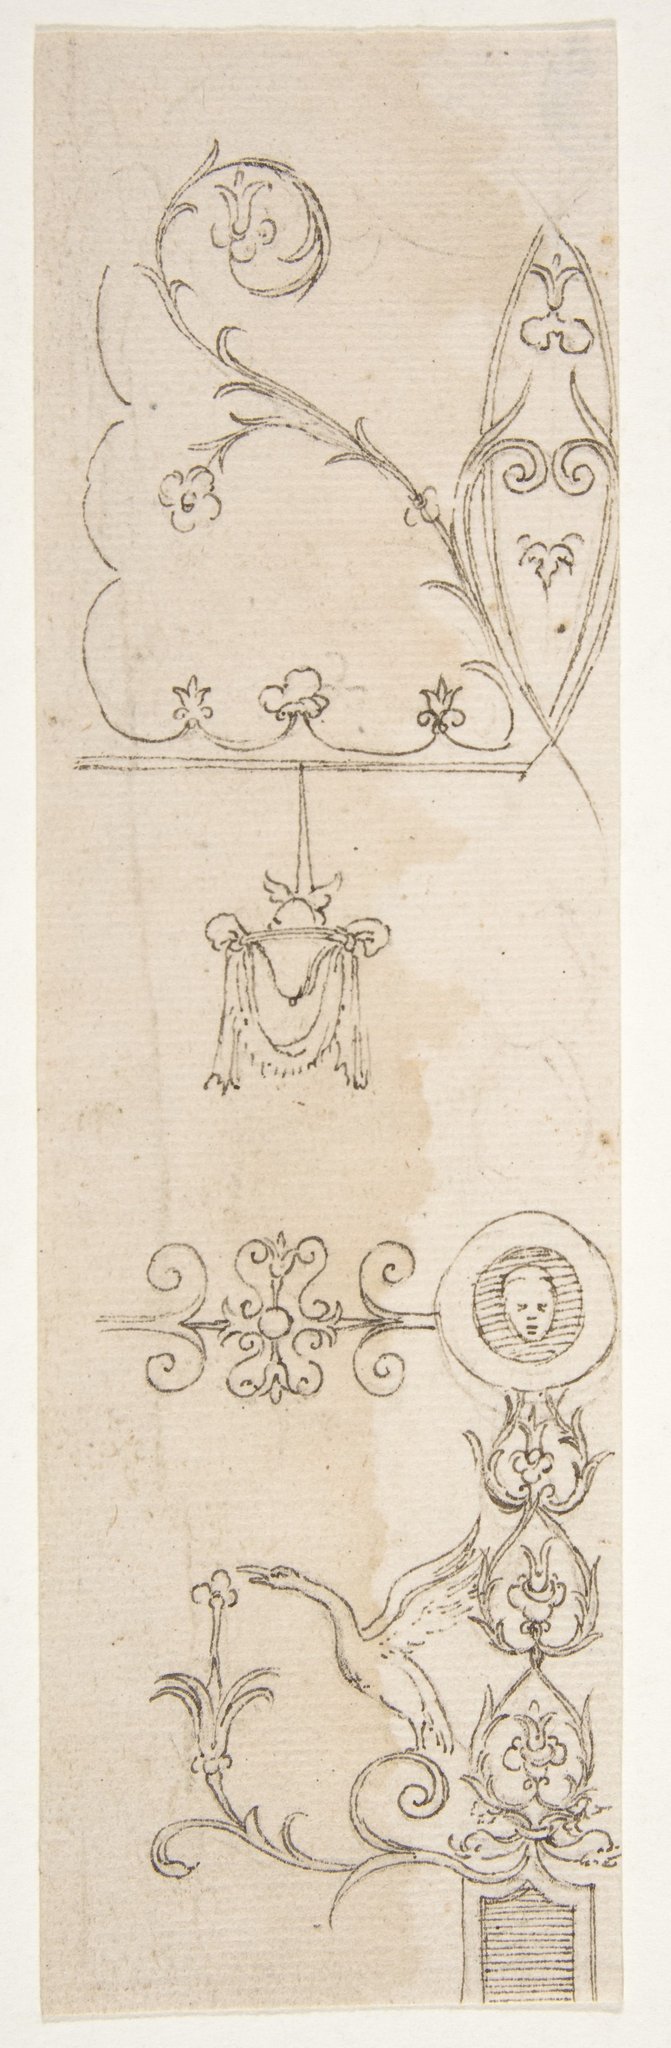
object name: collection ornament architecture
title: Domus Aurea, unidentified, grotteschi, details (recto) blank (verso)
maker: anonymous, french, 16th century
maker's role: draftsman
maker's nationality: french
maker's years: 1500-1600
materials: chalk, ink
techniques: incising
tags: birds,grotesques,ornament